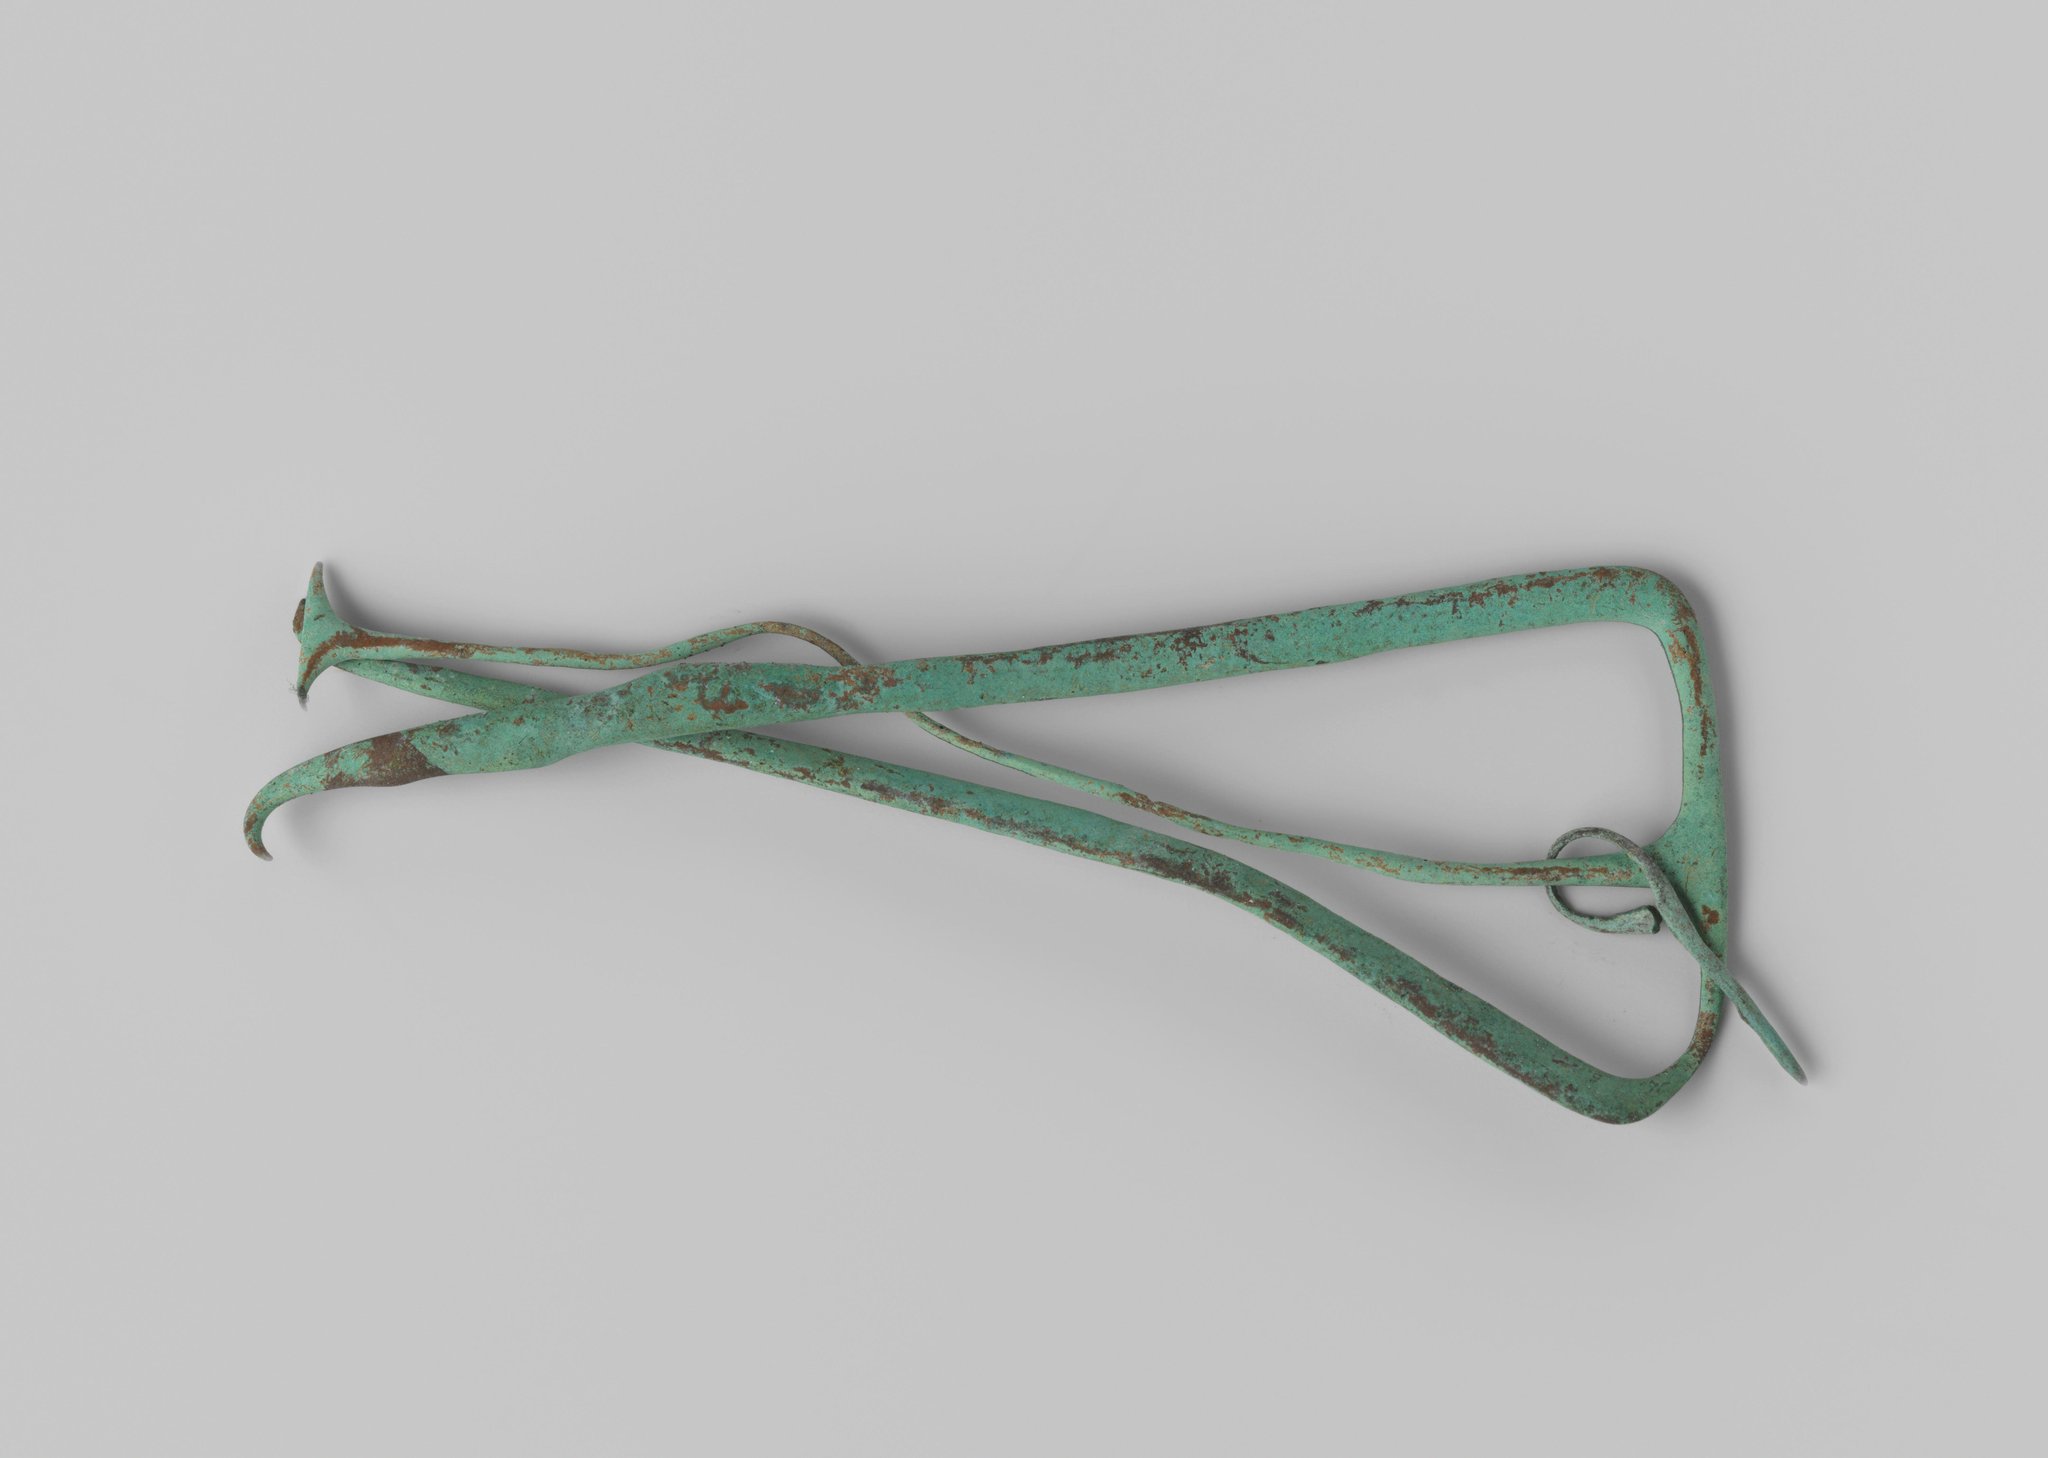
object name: belt buckle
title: Fragment riemgesp uit het wrak van de Oost-Indiëvaarder Hollandia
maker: Anonymous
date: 1700-1743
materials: copper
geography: netherlands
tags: verenigde oostindische compagnie, hollandia (schip), annet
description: Rectangular, ring with spindle and tongue, heavily eroded, id. NG 1980-27H2852, belt buckle.